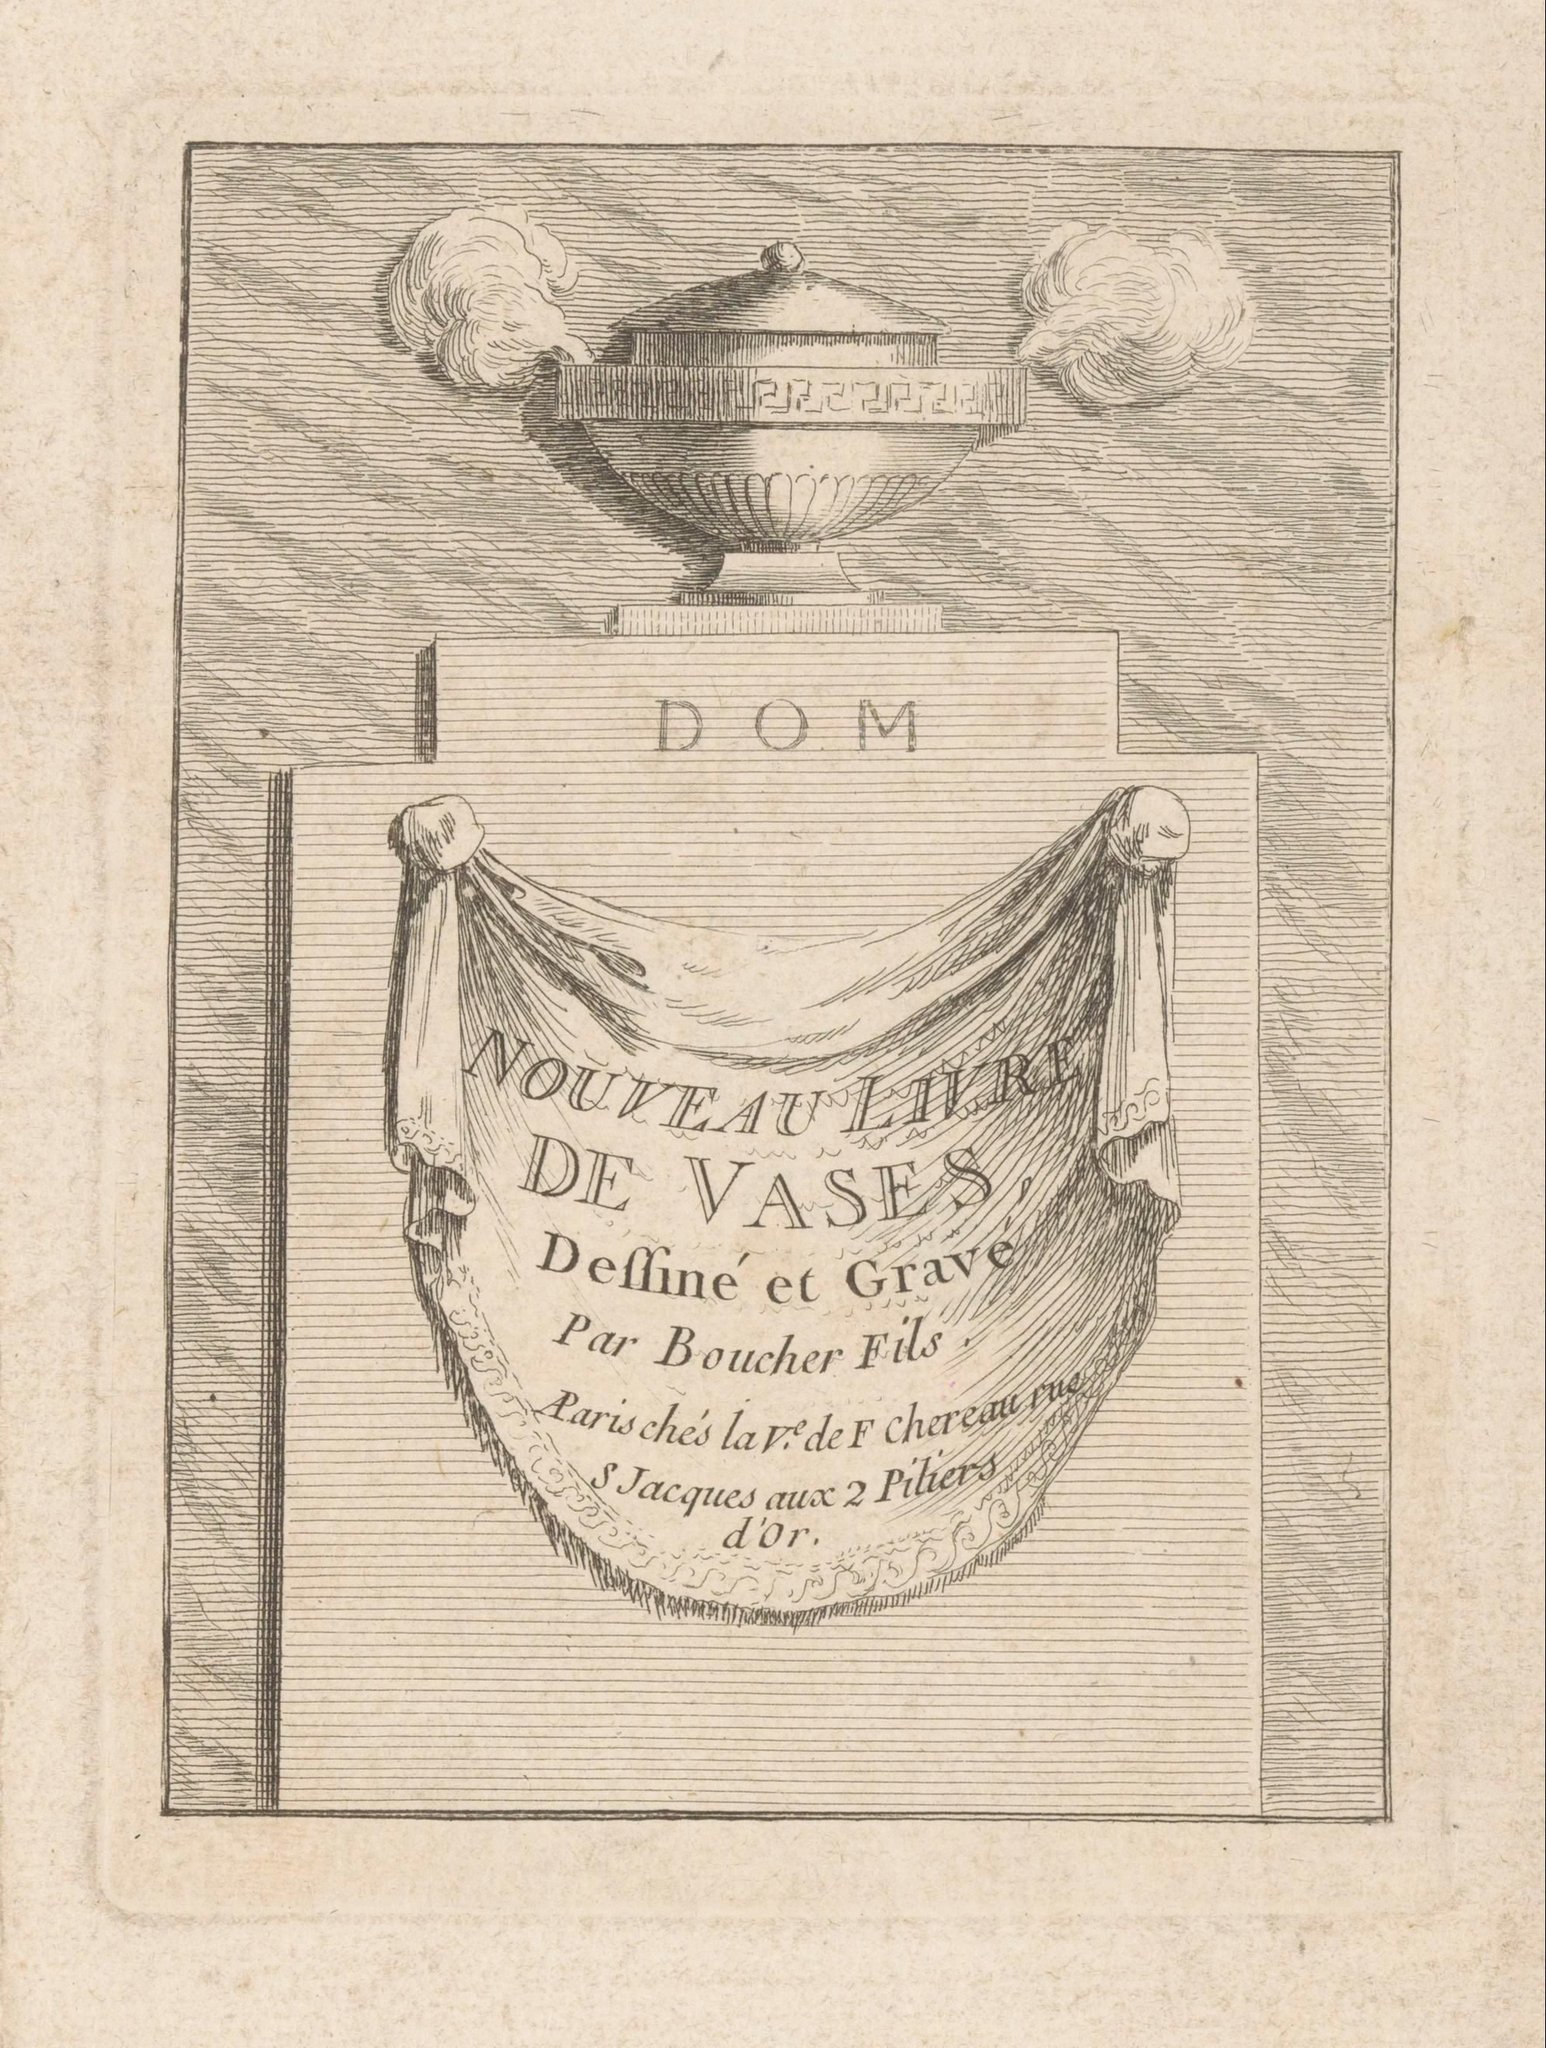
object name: print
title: Vaas met masker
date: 1755-1782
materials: paper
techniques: etching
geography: paris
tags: vase ~ ornament, mask, mascaron ~ ornament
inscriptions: collector's mark: Lugt 2228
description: Deze prent is onderdeel van een serie van acht.